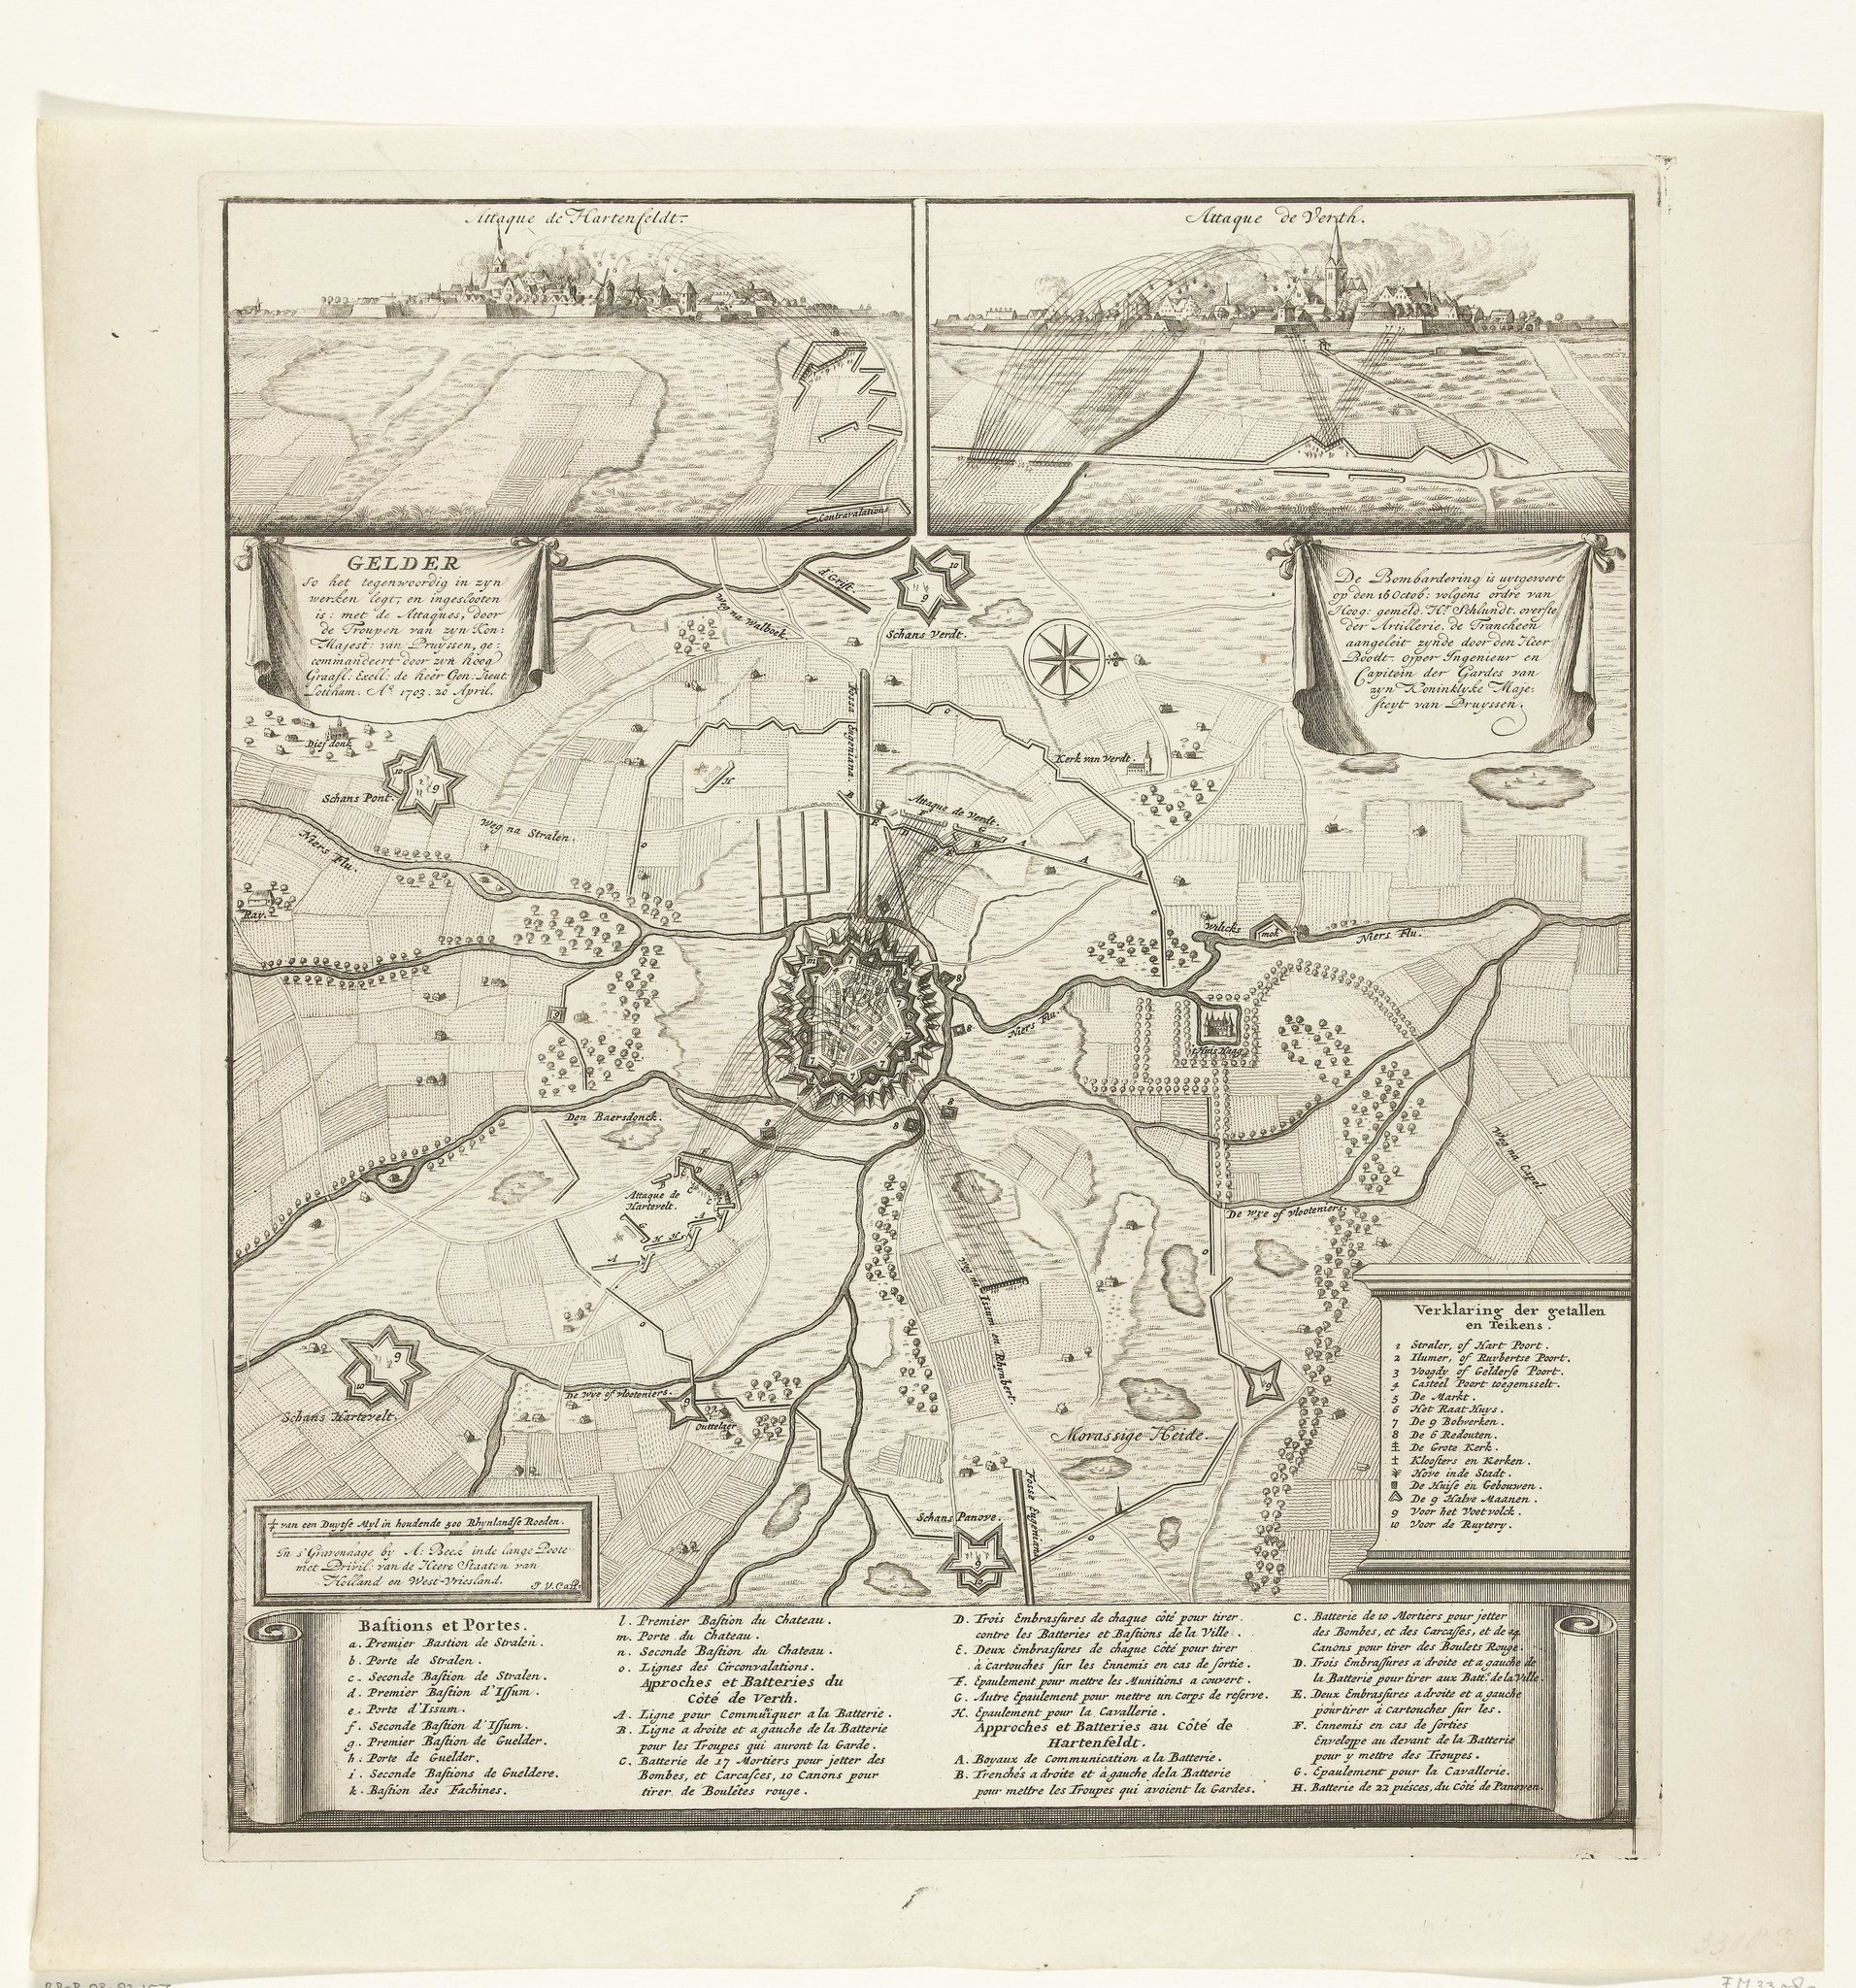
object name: map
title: Gelder so het tegenwoordig in zyn werken legt, en ingeslooten is: met de attaques, door de troupen van zyn kon. majest. van Pruyssen, gecommandeert door zyn hoog. graafl. excell. de heer gen. lieut. Lotthum. ao. 1703. 20 april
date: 1703-1717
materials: paper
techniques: engraving, etching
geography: the hague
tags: siege, position war, maps of cities, bombardment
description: Kaart van Geldern en omgeving, tijdens het beleg door de Pruisische troepen onder generaal Lotthum op 20 april. Bovenaan het bombardement van de stad op 7 oktober 1703 gezien vanuit Hartenfeldt en Verth. Onderaan de verklaringen in het Frans.